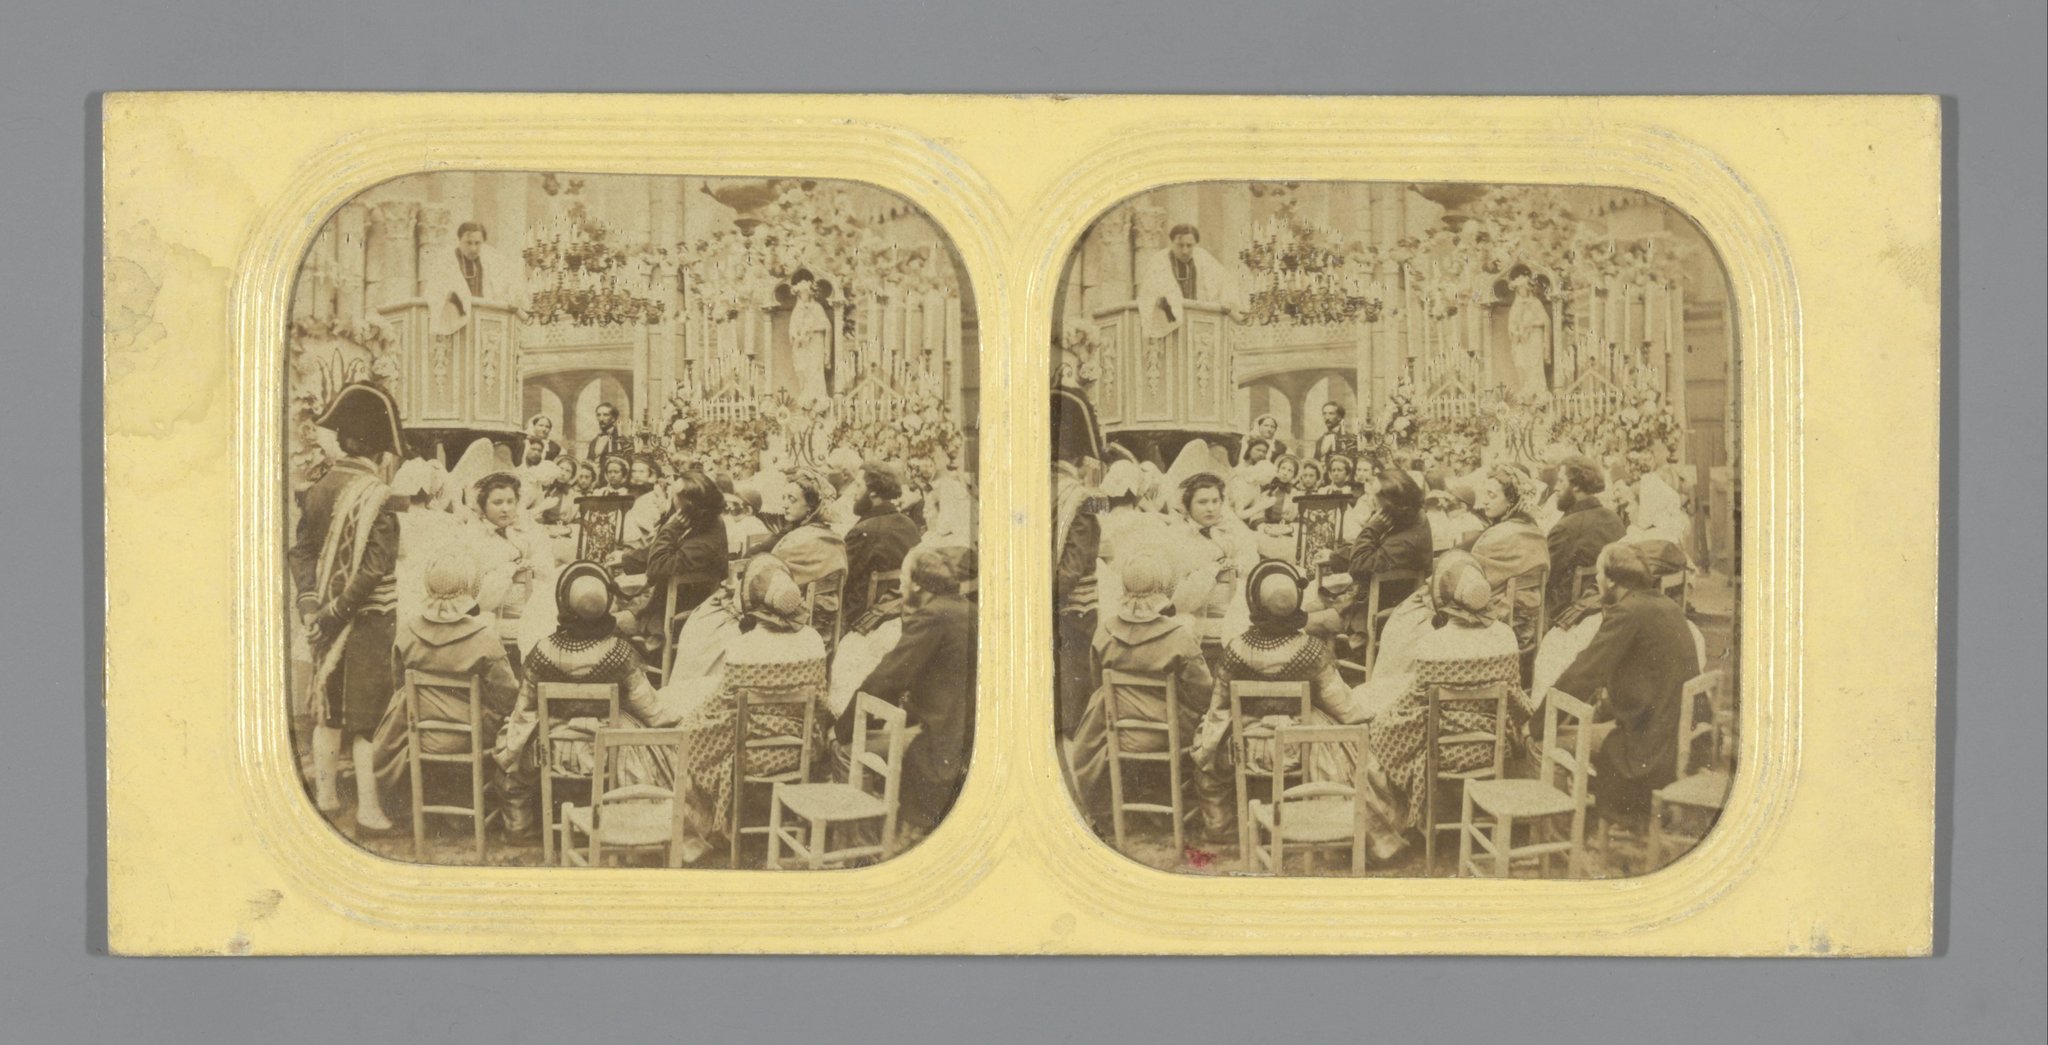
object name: tissue stereograph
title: Predikant spreekt vanaf kansel kerkgangers toe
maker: Anonymous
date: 1855-1875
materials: cardboard, paper, photographic support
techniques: albumen print, cutting, hand coloring, perforating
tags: organization, functionaries and dignitaries in churches and in related institutions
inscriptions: retailer's mark: ‘Au Jardin des Tuileries/ 202 rue de Rivoli/ B. GUÉRARD/ Grand Assortim de Stereoscopes et Vues/ Stéréoscopiques de l'ons pays (...)’